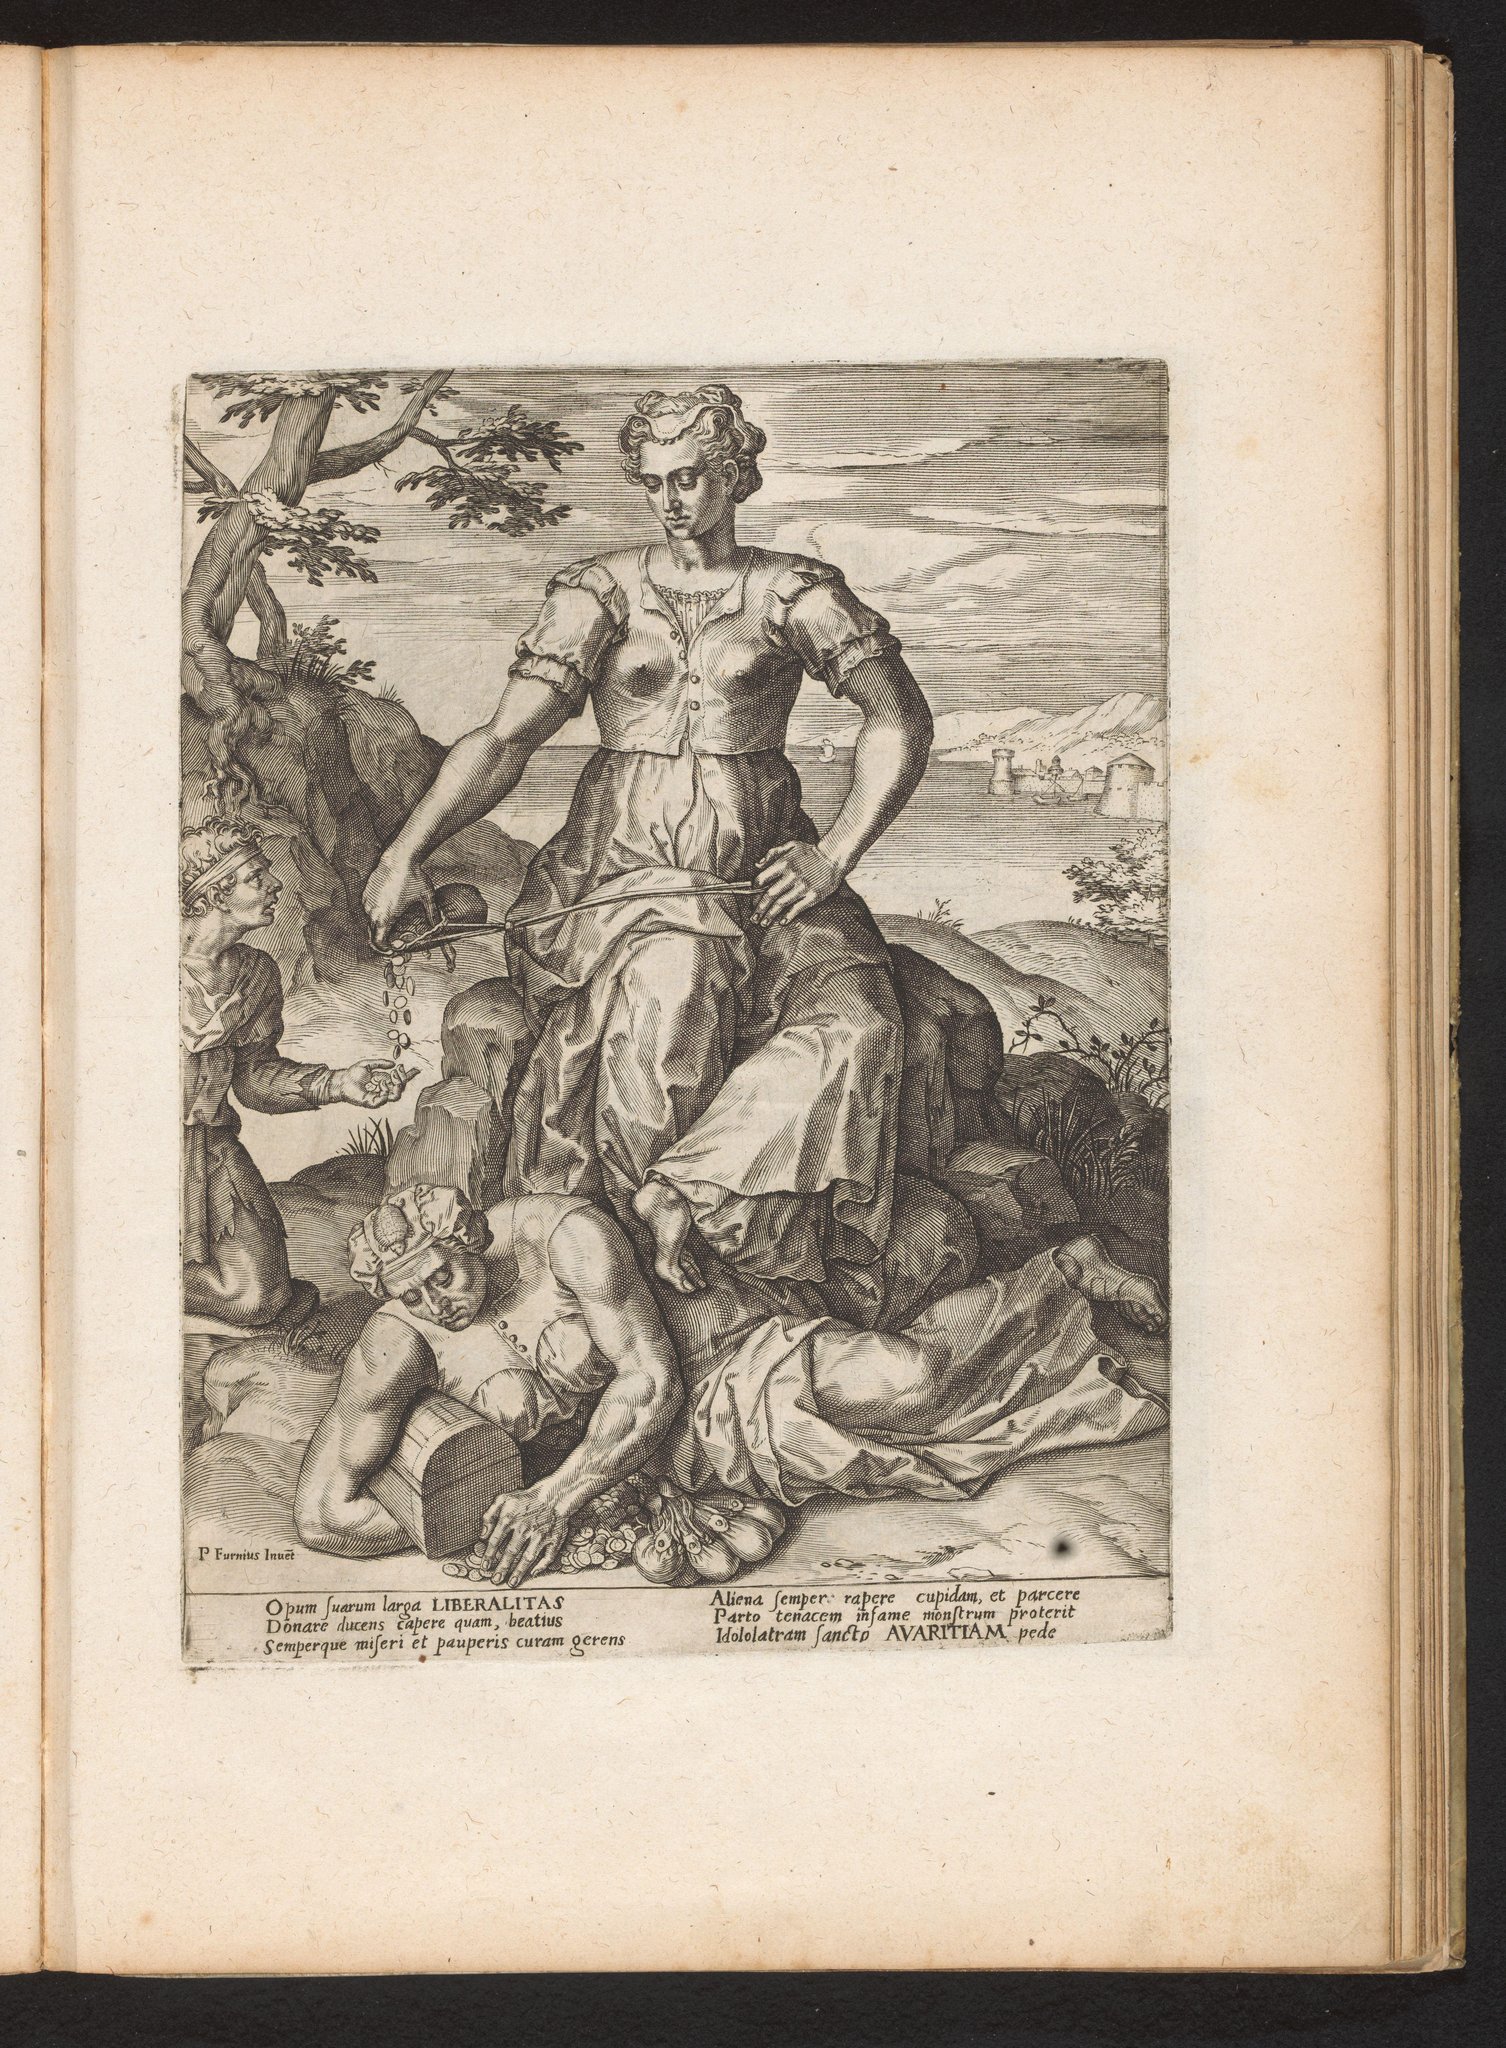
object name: album leaf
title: Vrijgevigheid overwint Gierigheid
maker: pieter jalhea furnius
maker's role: print maker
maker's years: 1540-1626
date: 1550-1625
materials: paper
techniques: engraving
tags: purse, money-bag, covetousness; 'avaritia' (ripa) ~ personification of one of the seven deadly sins, one virtue fighting against or treading upon one vice, generosity, liberality; 'generosità', 'liberalità' (ripa)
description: De Vrijgevigheid geeft geld aan een arme man terwijl ze de Gierigheid, die haar geldstukken telt, onder de voet vertreedt. Deze prent maakt deel uit van een album.